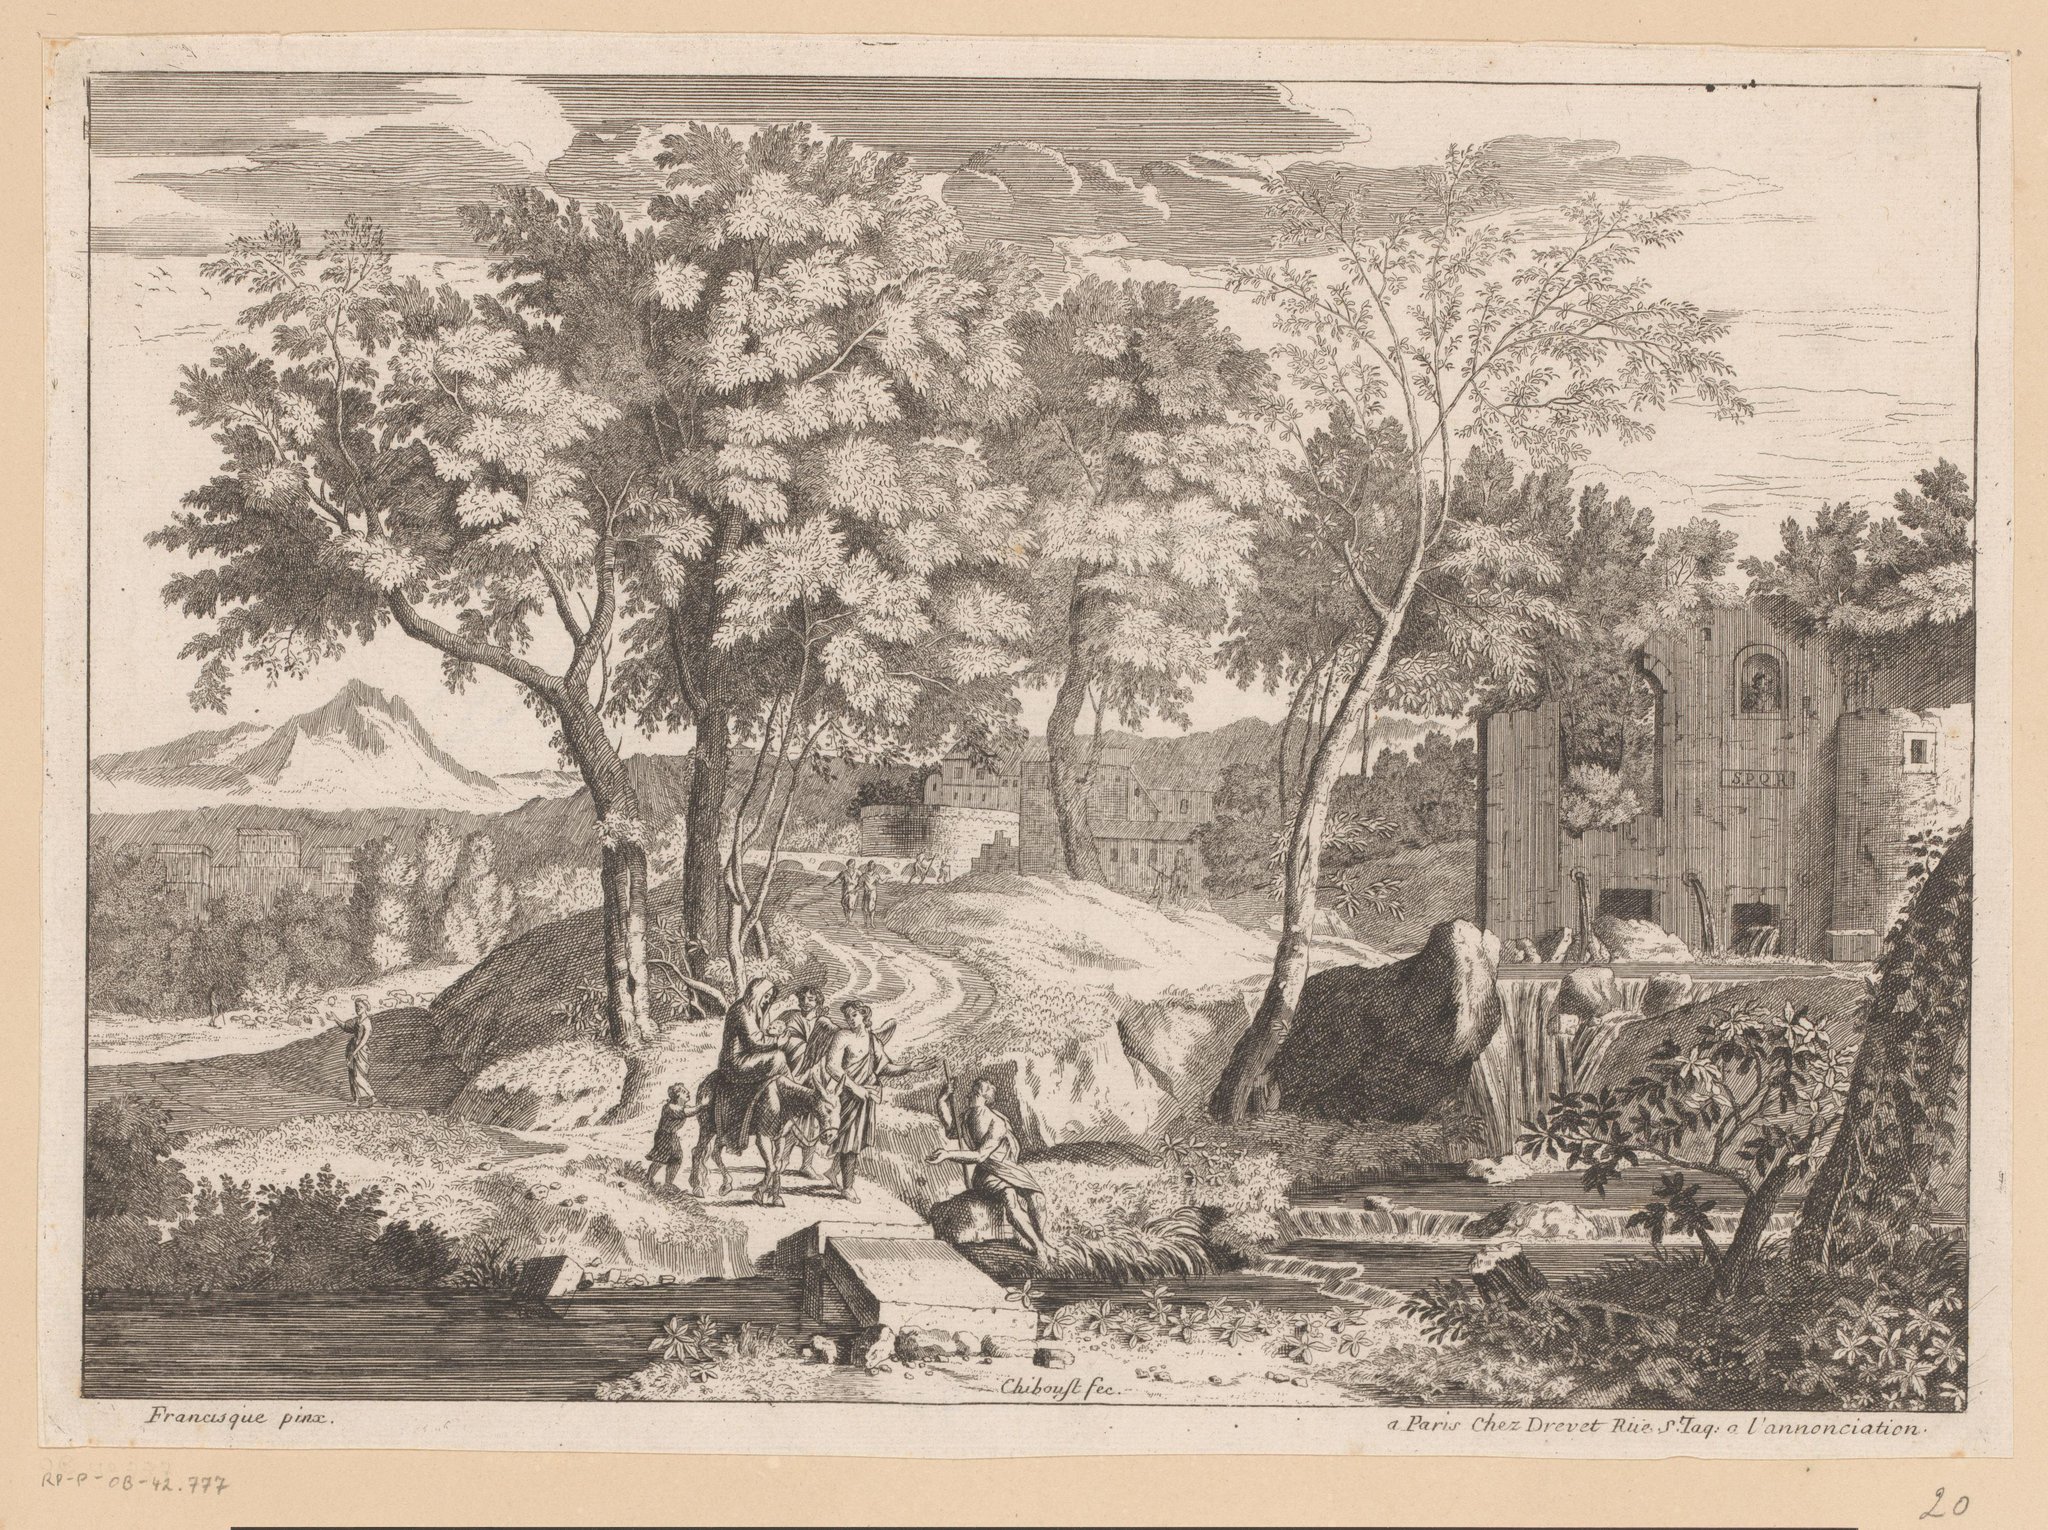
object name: print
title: Landschap met vlucht naar Egypte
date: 1700-1738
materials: paper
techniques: etching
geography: france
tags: river - hh - ideal landscapes, rest on the flight into egypt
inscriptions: collector's mark: Lugt 240